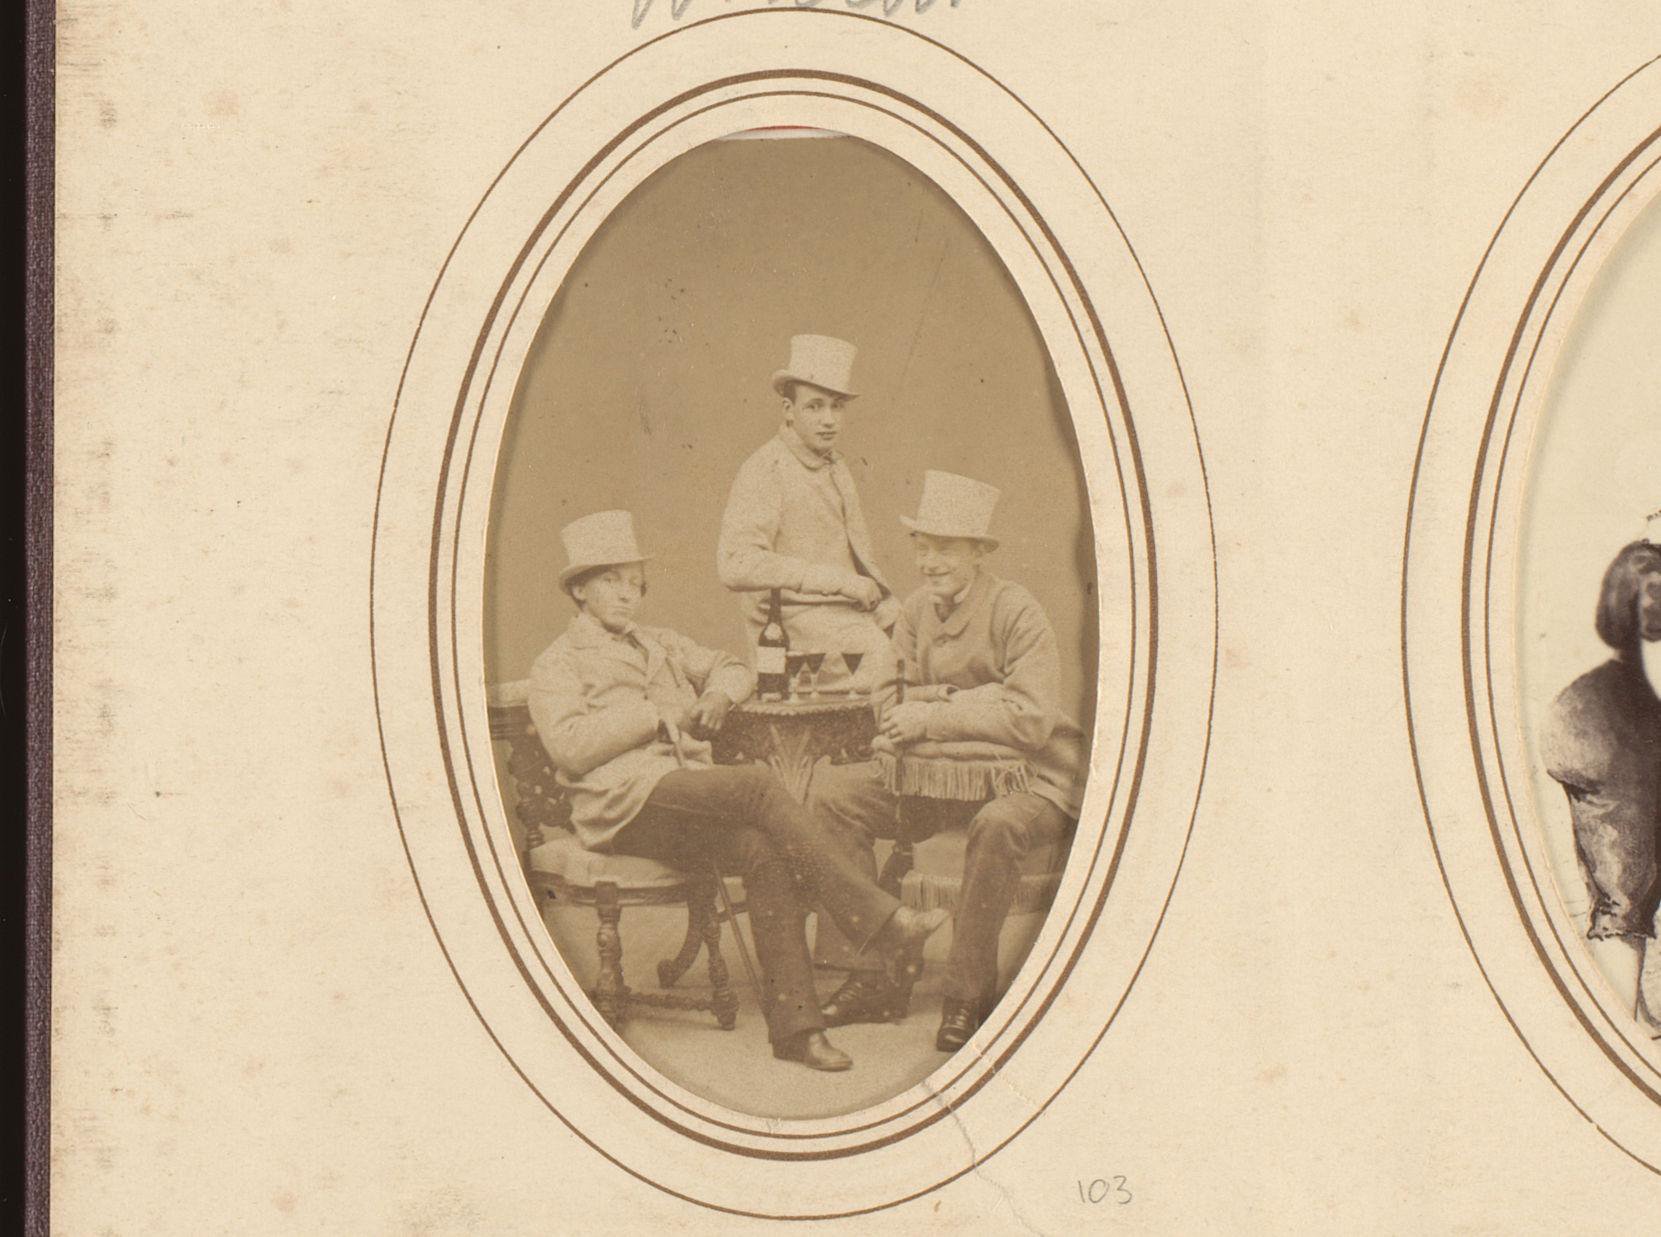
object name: photograph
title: Portret van drie mannen met hoeden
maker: george lodewijk mulder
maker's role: fotograaf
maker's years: 1841-1920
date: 1865-1890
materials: cardboard, photographic support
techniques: albumen print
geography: utrecht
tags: adult man, head-gear: hat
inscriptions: inscription: ‘Photogr. Atelier / G.L. Mulder / van Wijckskade H. 326 / UTRECHT’, inscription: ‘G.L. MULDER Utrecht.’